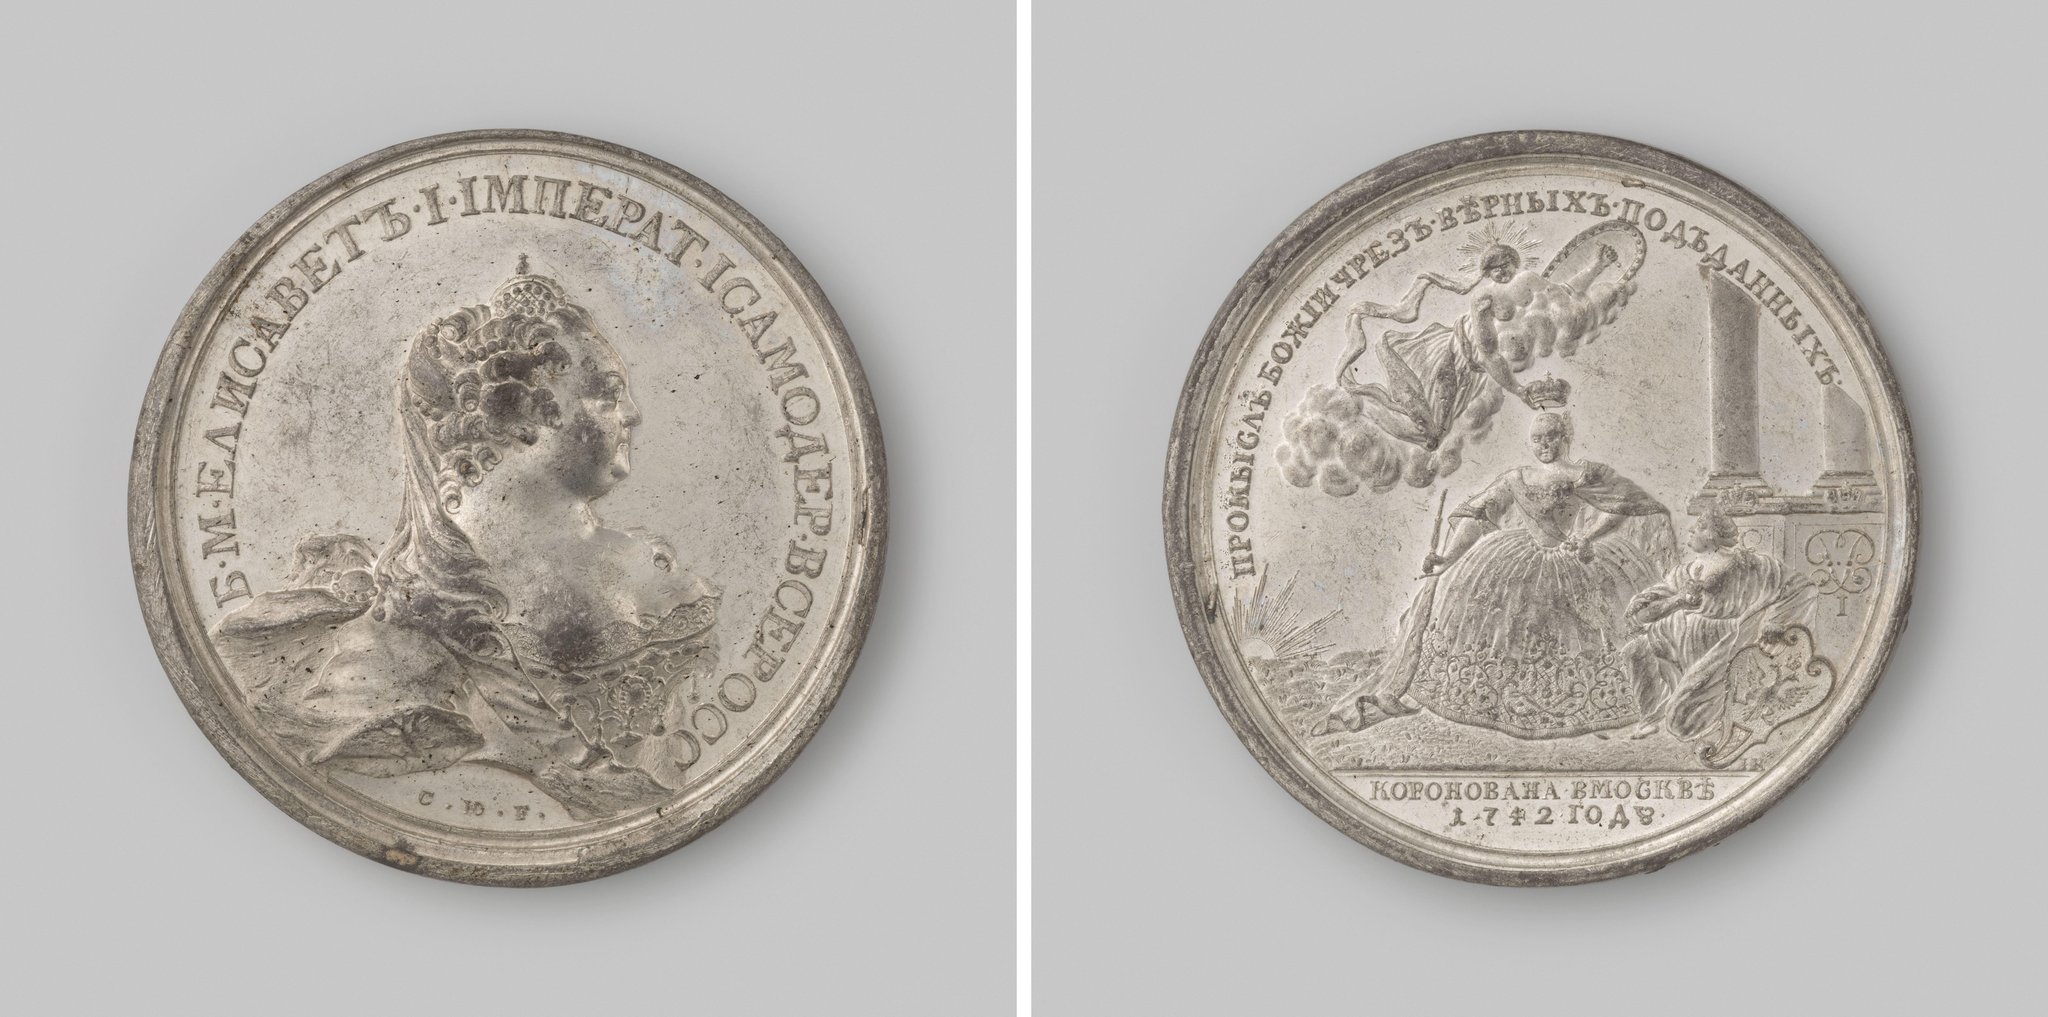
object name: history medal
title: Kroning van Tsarina Elisabeth in Moskou 1742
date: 1742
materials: tin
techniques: striking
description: Tinnen penning, op de voorzijde het borstbeeld van Tsarina Elisabeth naar rechts met omschrift, op de keerzijde Elisabeth met scepter gekroond door een genius op een wolk en aanbeden door Rusland als een knielende man, op de achtergrond een zonbeschenen landschap en twee zuilen op een voetstuk, met omschrift en afsnedetekst.